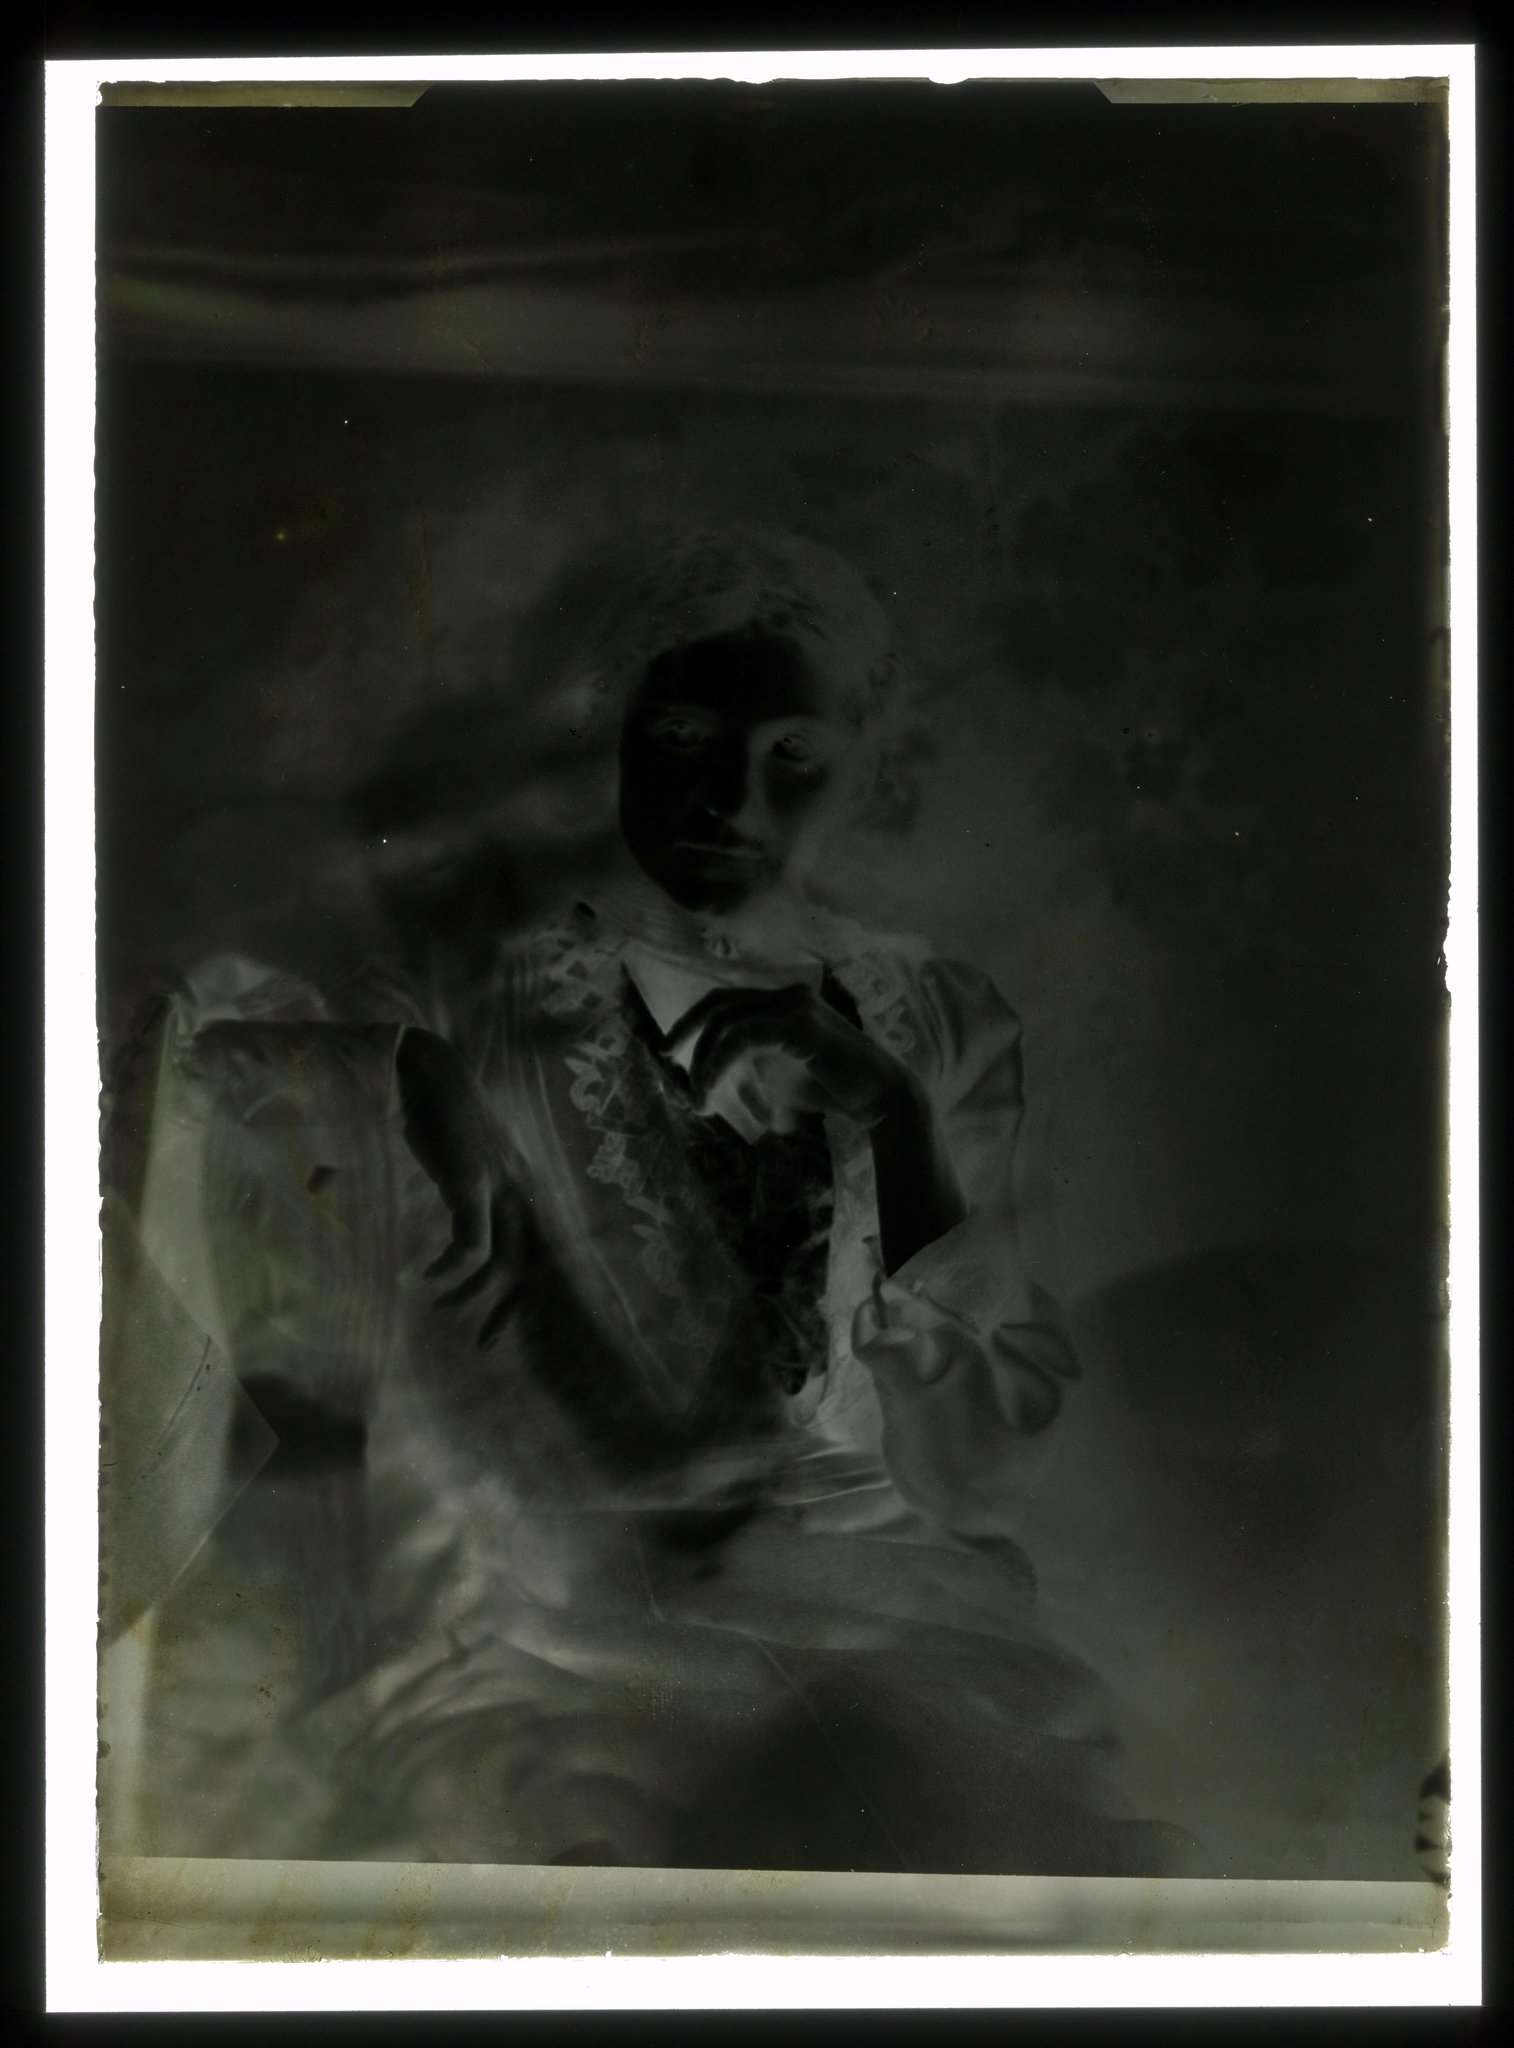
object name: glasnegatief, glasplaatnegatief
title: Portret van een vrouw, aangeduid als Louise Hartmann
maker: laurens lodewijk kleijn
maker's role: draughtsman, painter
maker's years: 1826-1909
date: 1865-1900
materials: glass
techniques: collodion process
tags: anonymous historical person portrayed - bb - woman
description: Onderdeel van een groep glasnegatieven uit de nalatenschap van de schilder Laurens Lodewijk Kleijn, met stillevens, portretten, zelfportretten en kunstreproducties.